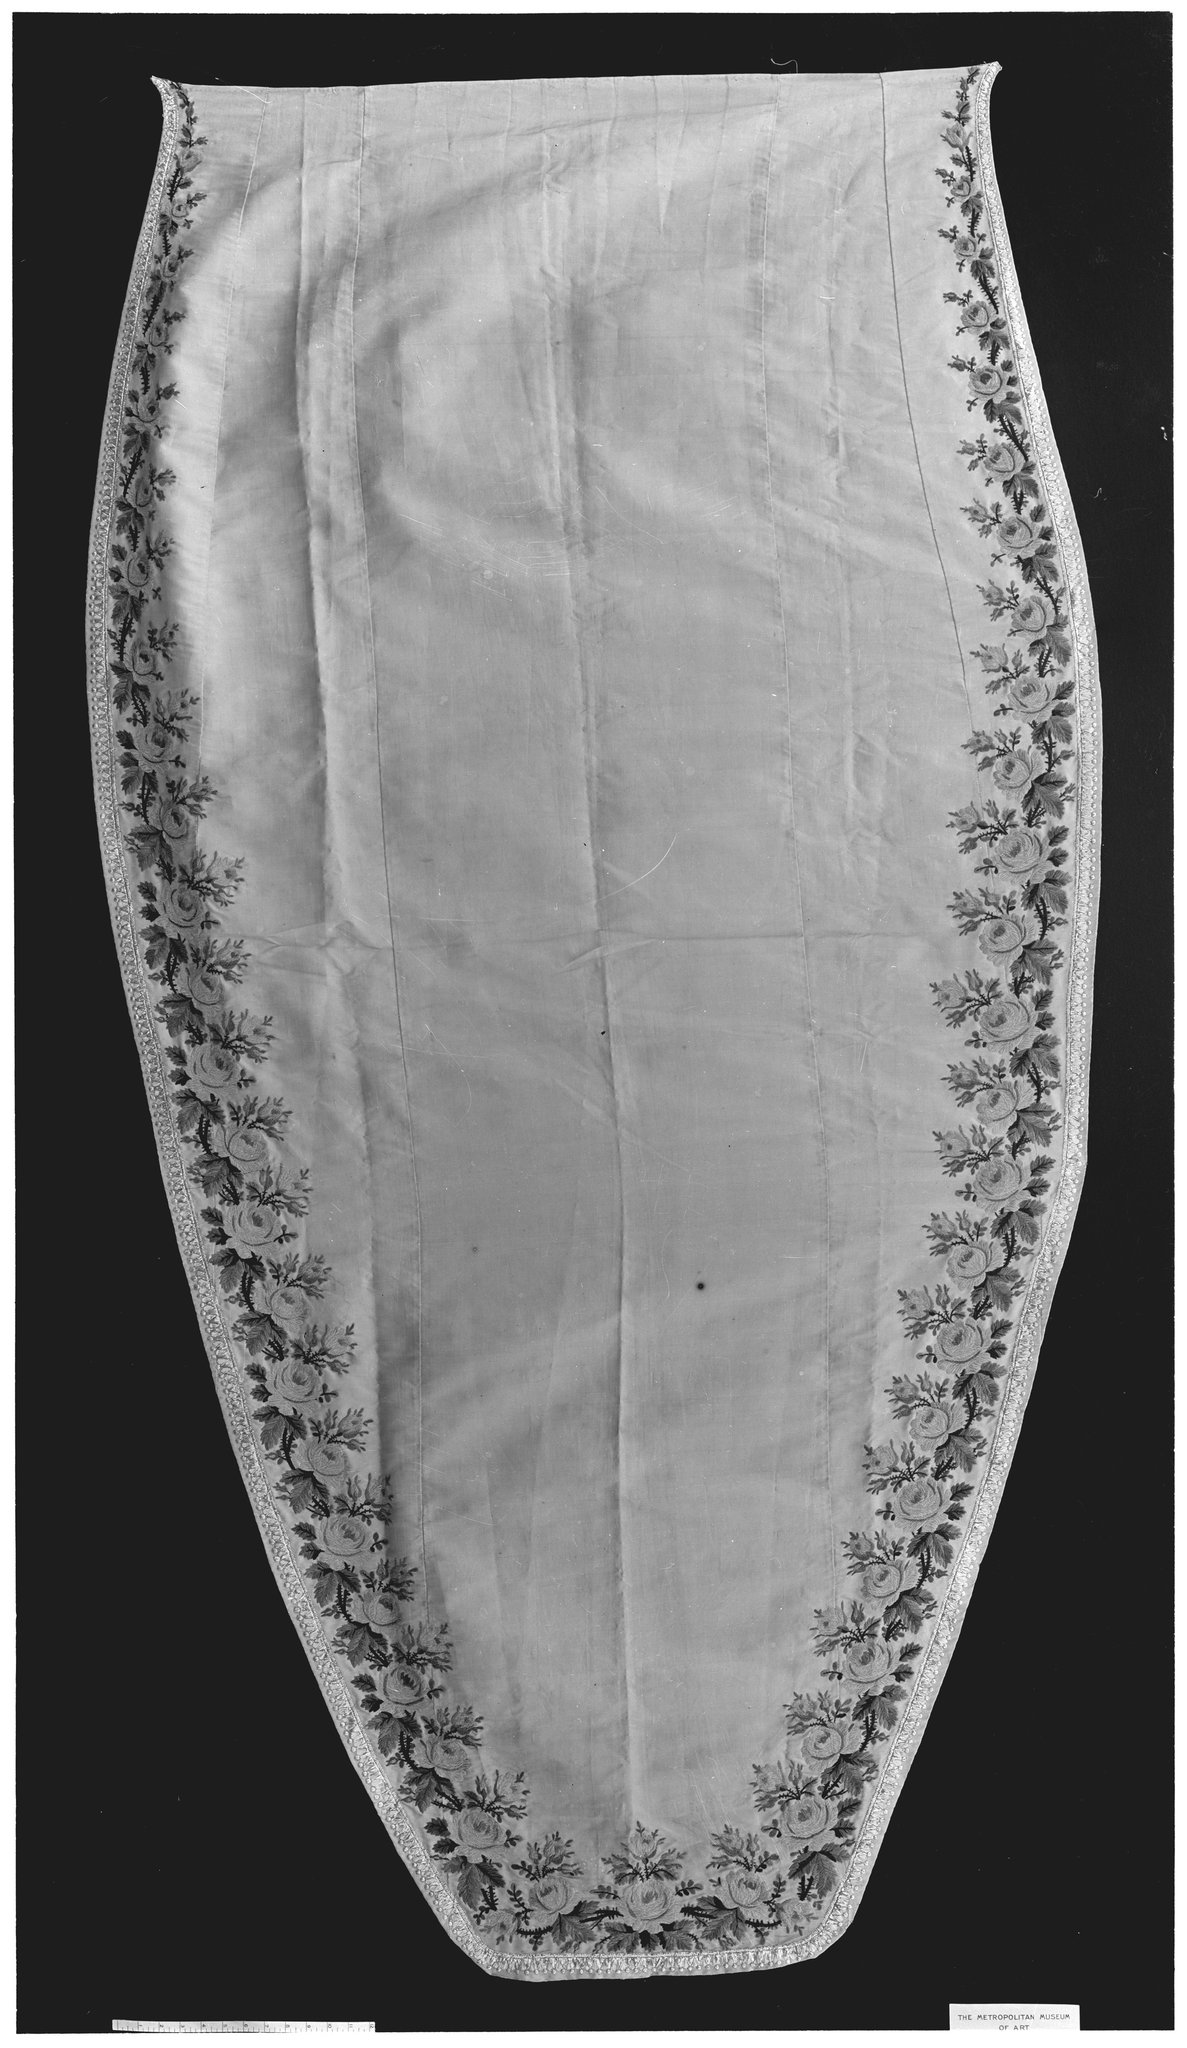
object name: court train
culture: german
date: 1801-1900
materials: metal thread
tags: roses